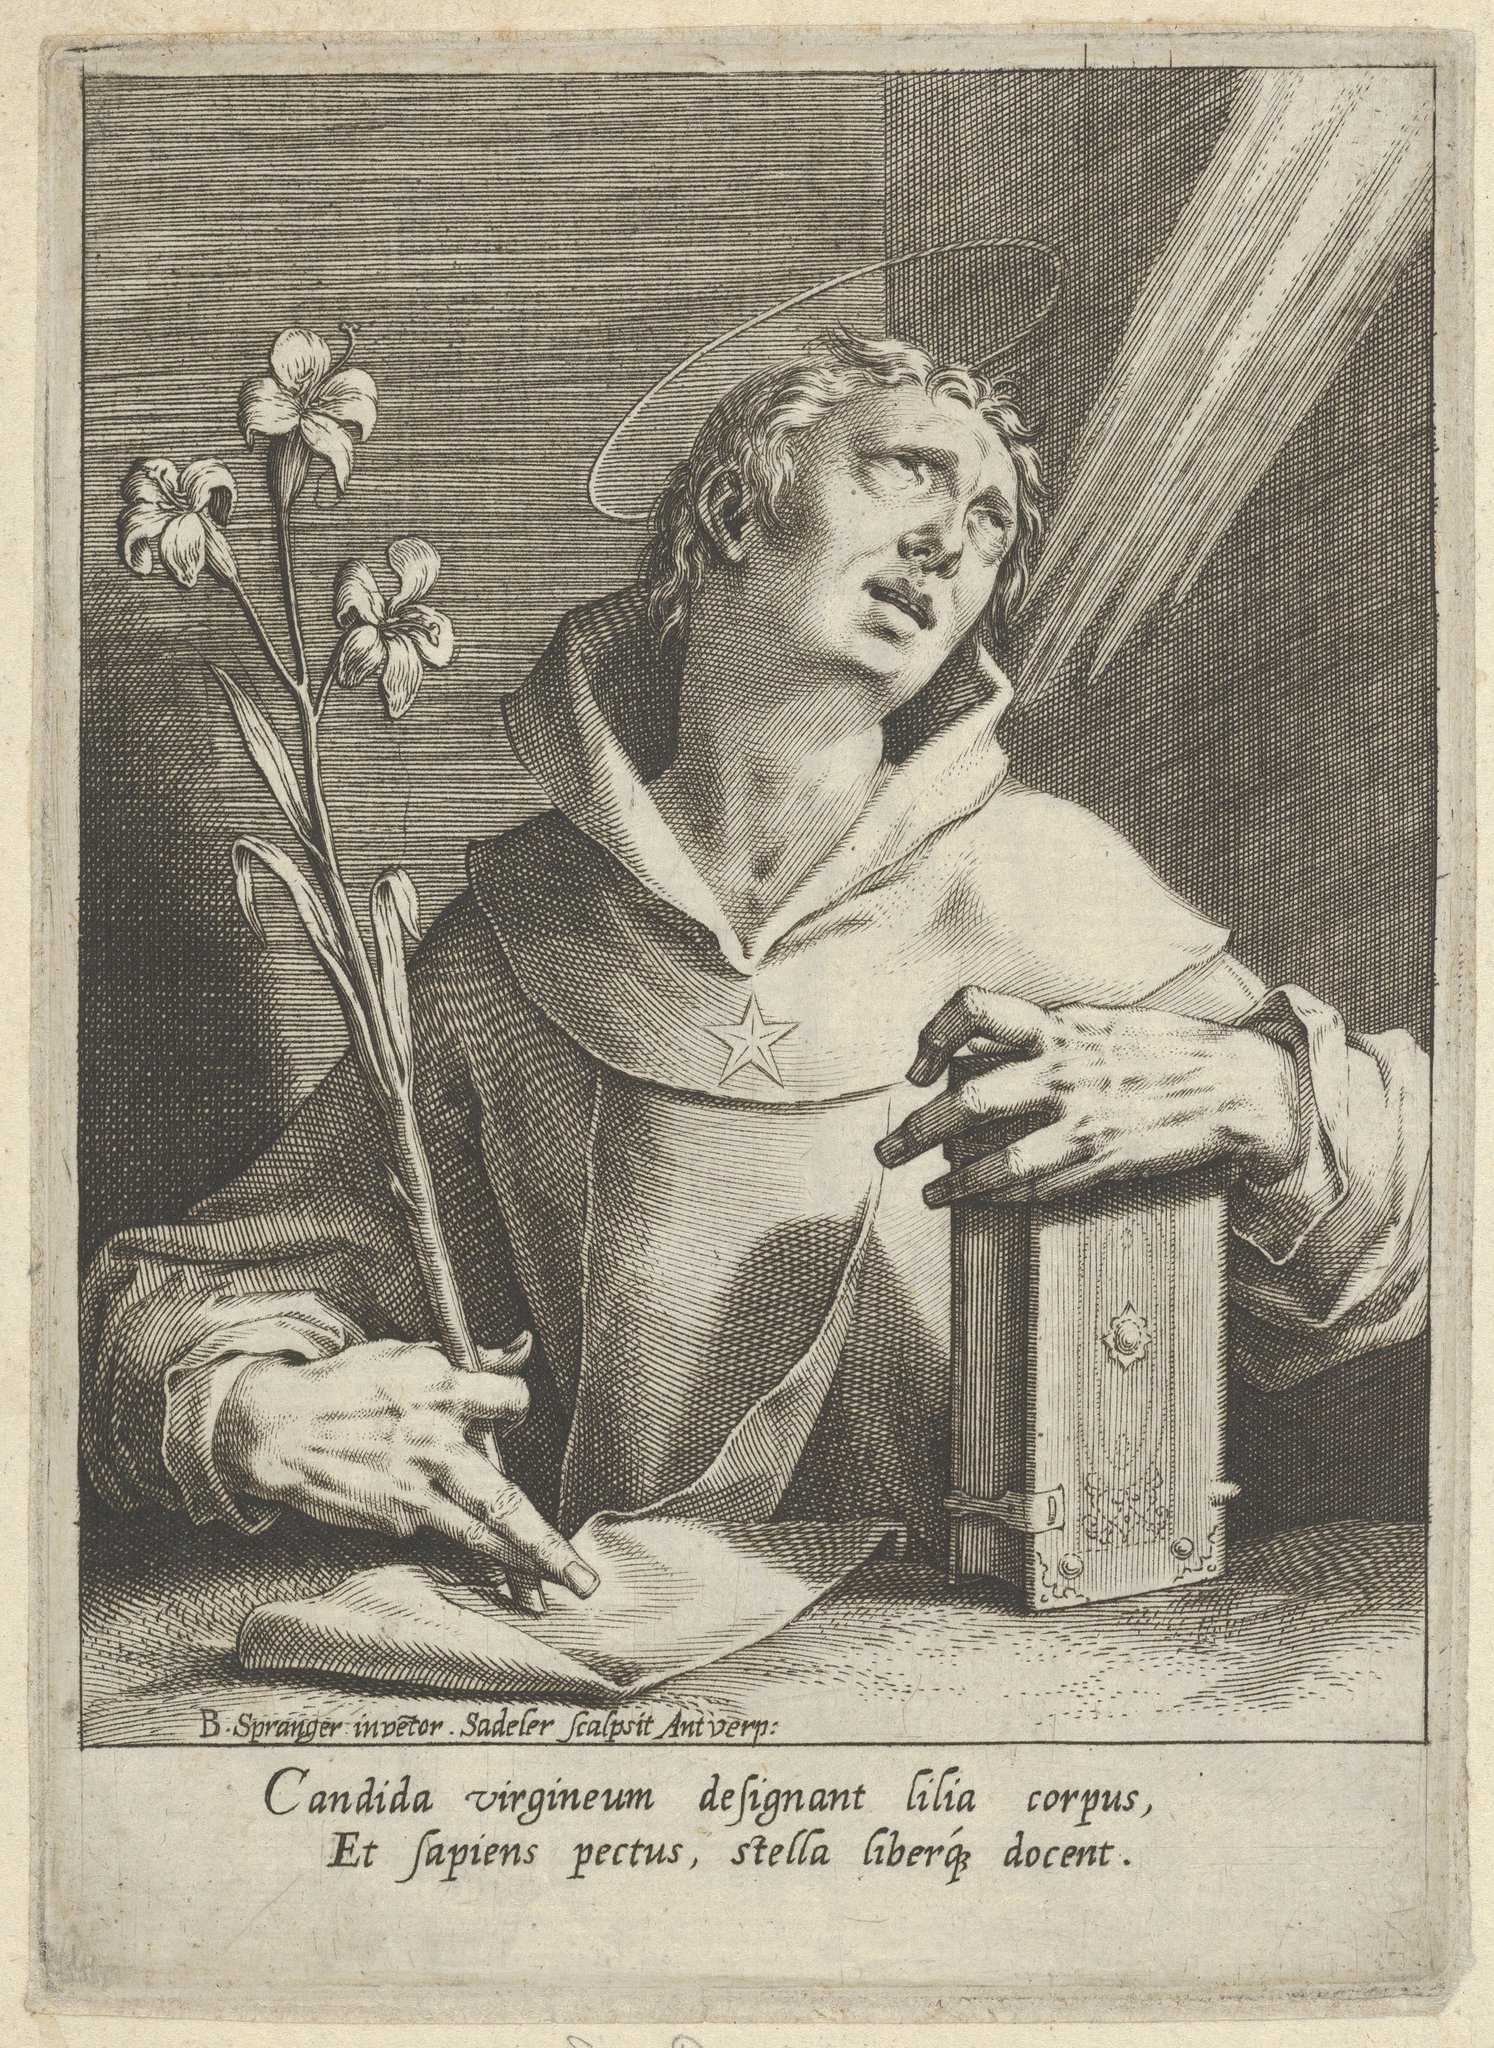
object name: print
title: Saint Dominic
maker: johann sadeler (i)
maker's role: artist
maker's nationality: netherlandish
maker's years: 1550-1601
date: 1582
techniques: engraving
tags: men,saints